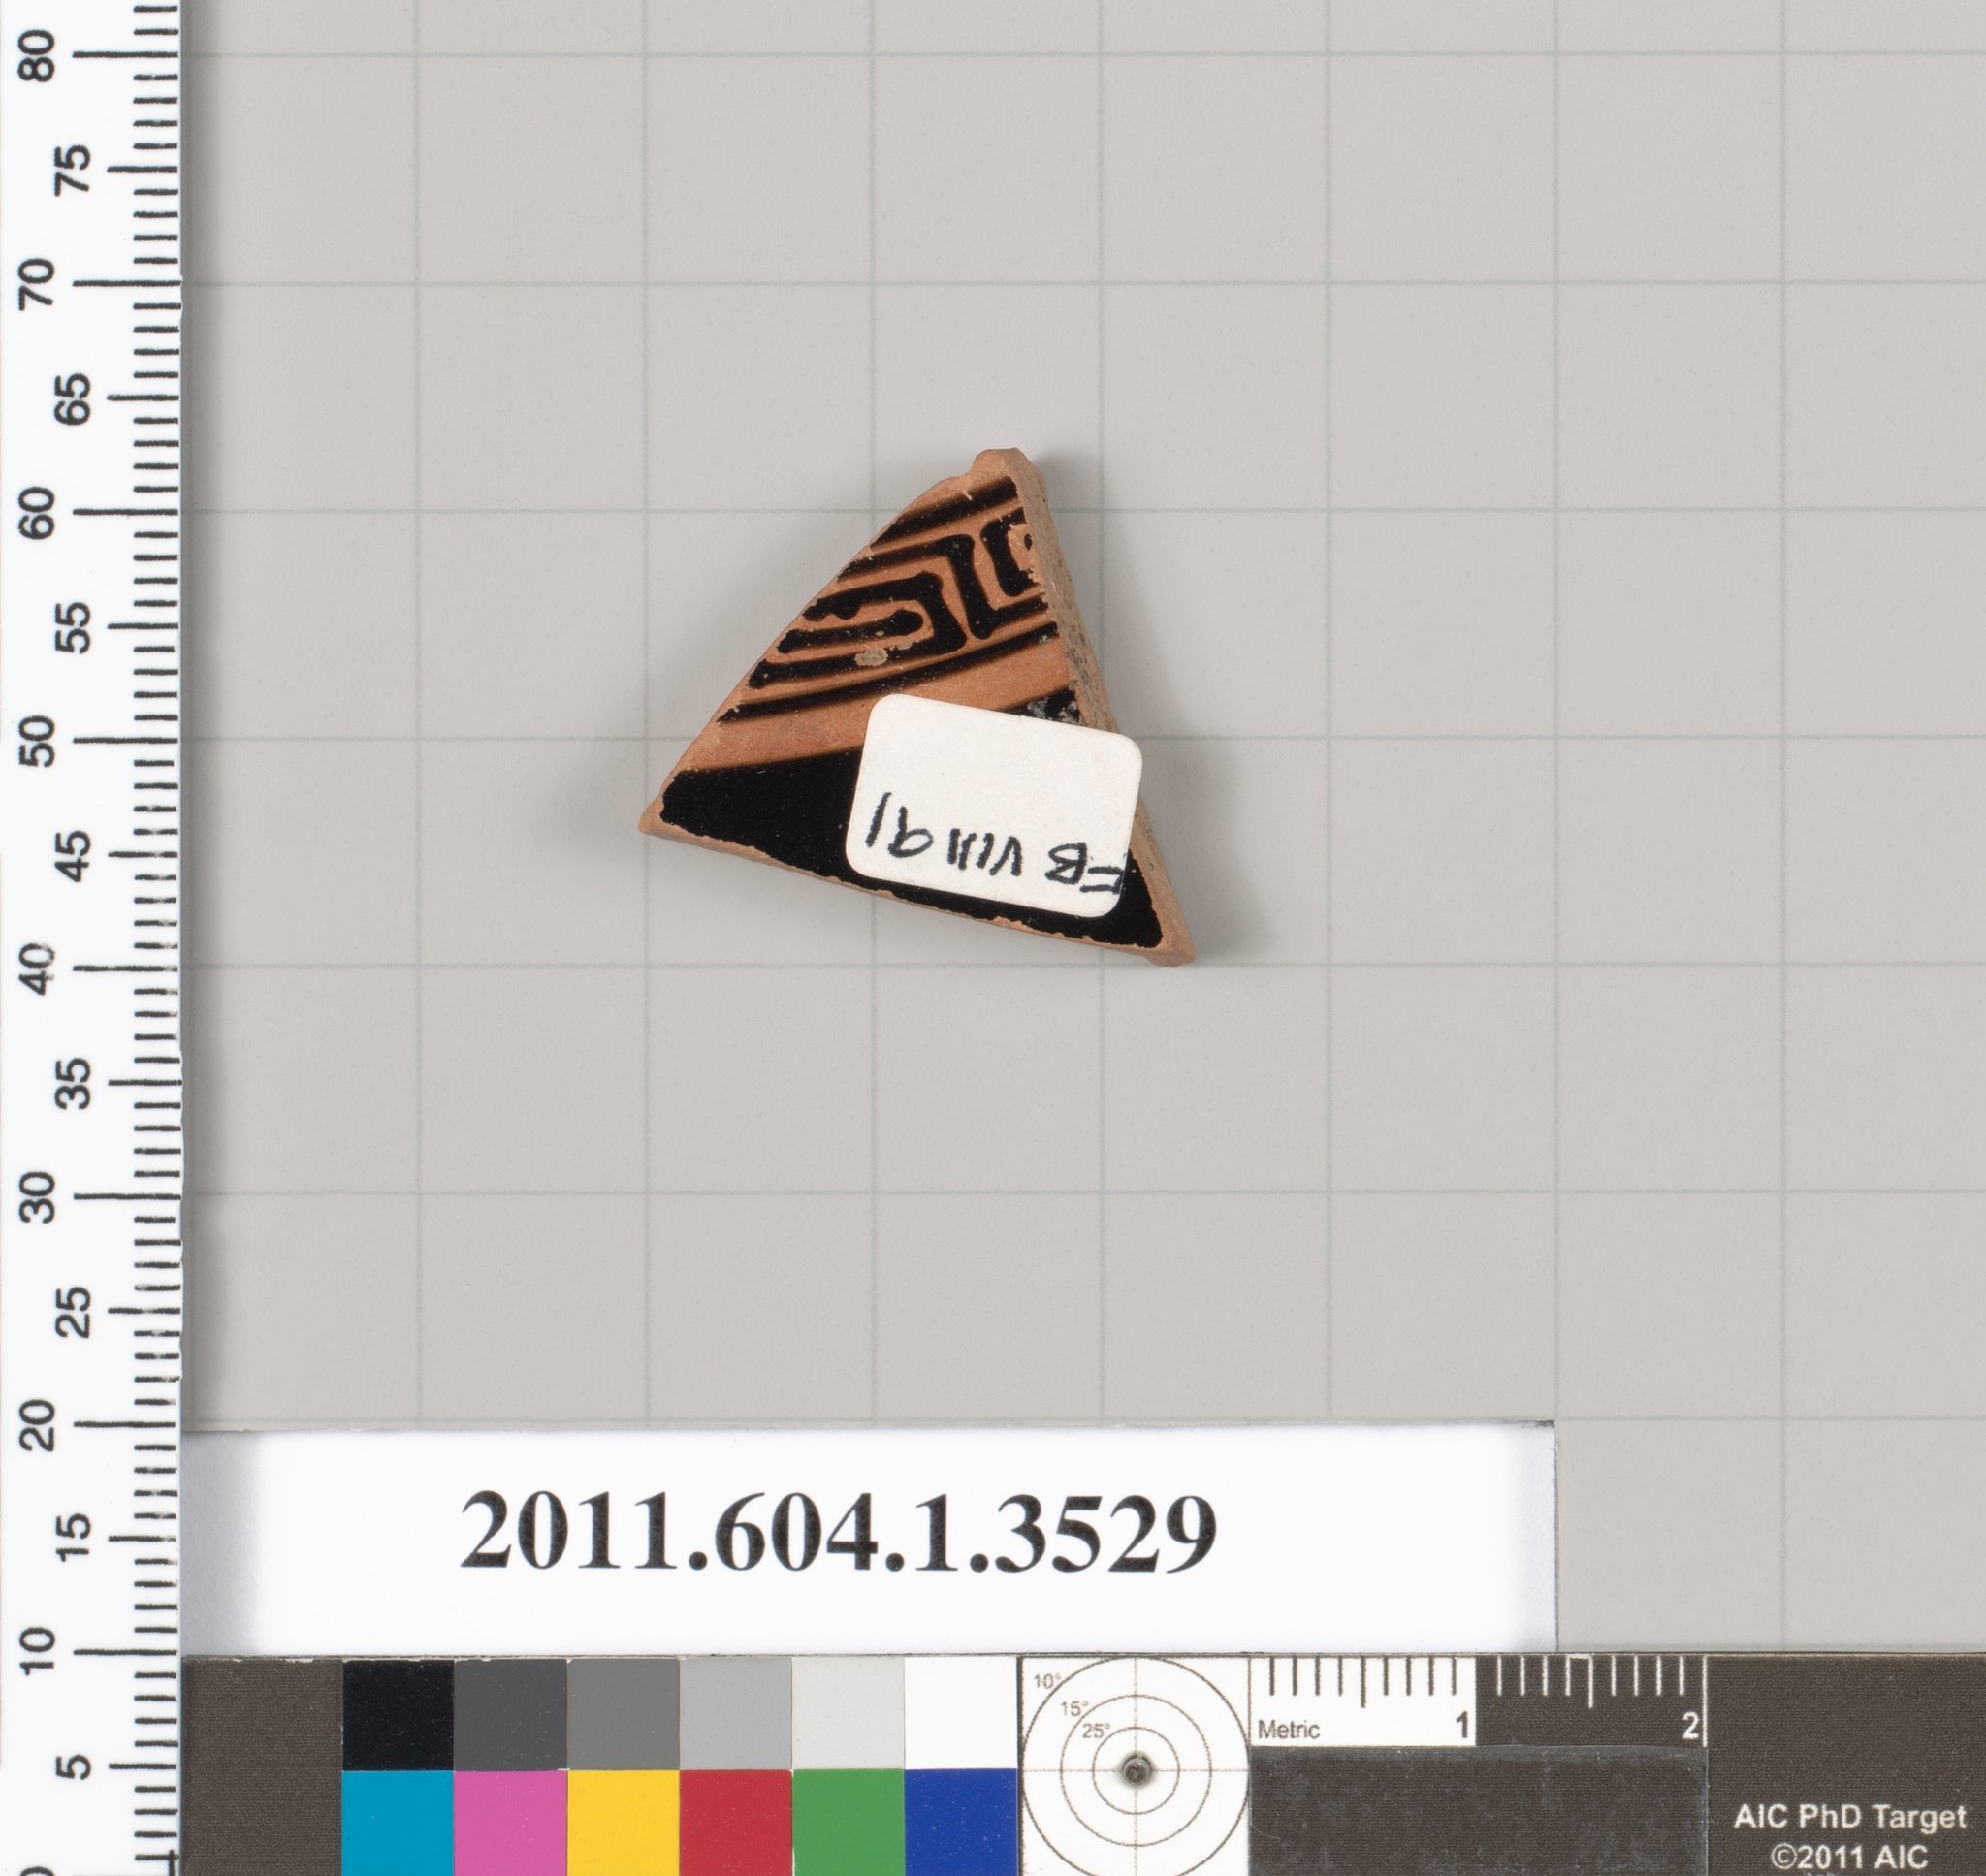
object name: kylix fragment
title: Terracotta fragment of a kylix (drinking cup)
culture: greek, attic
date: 475-451 BCE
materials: terracotta